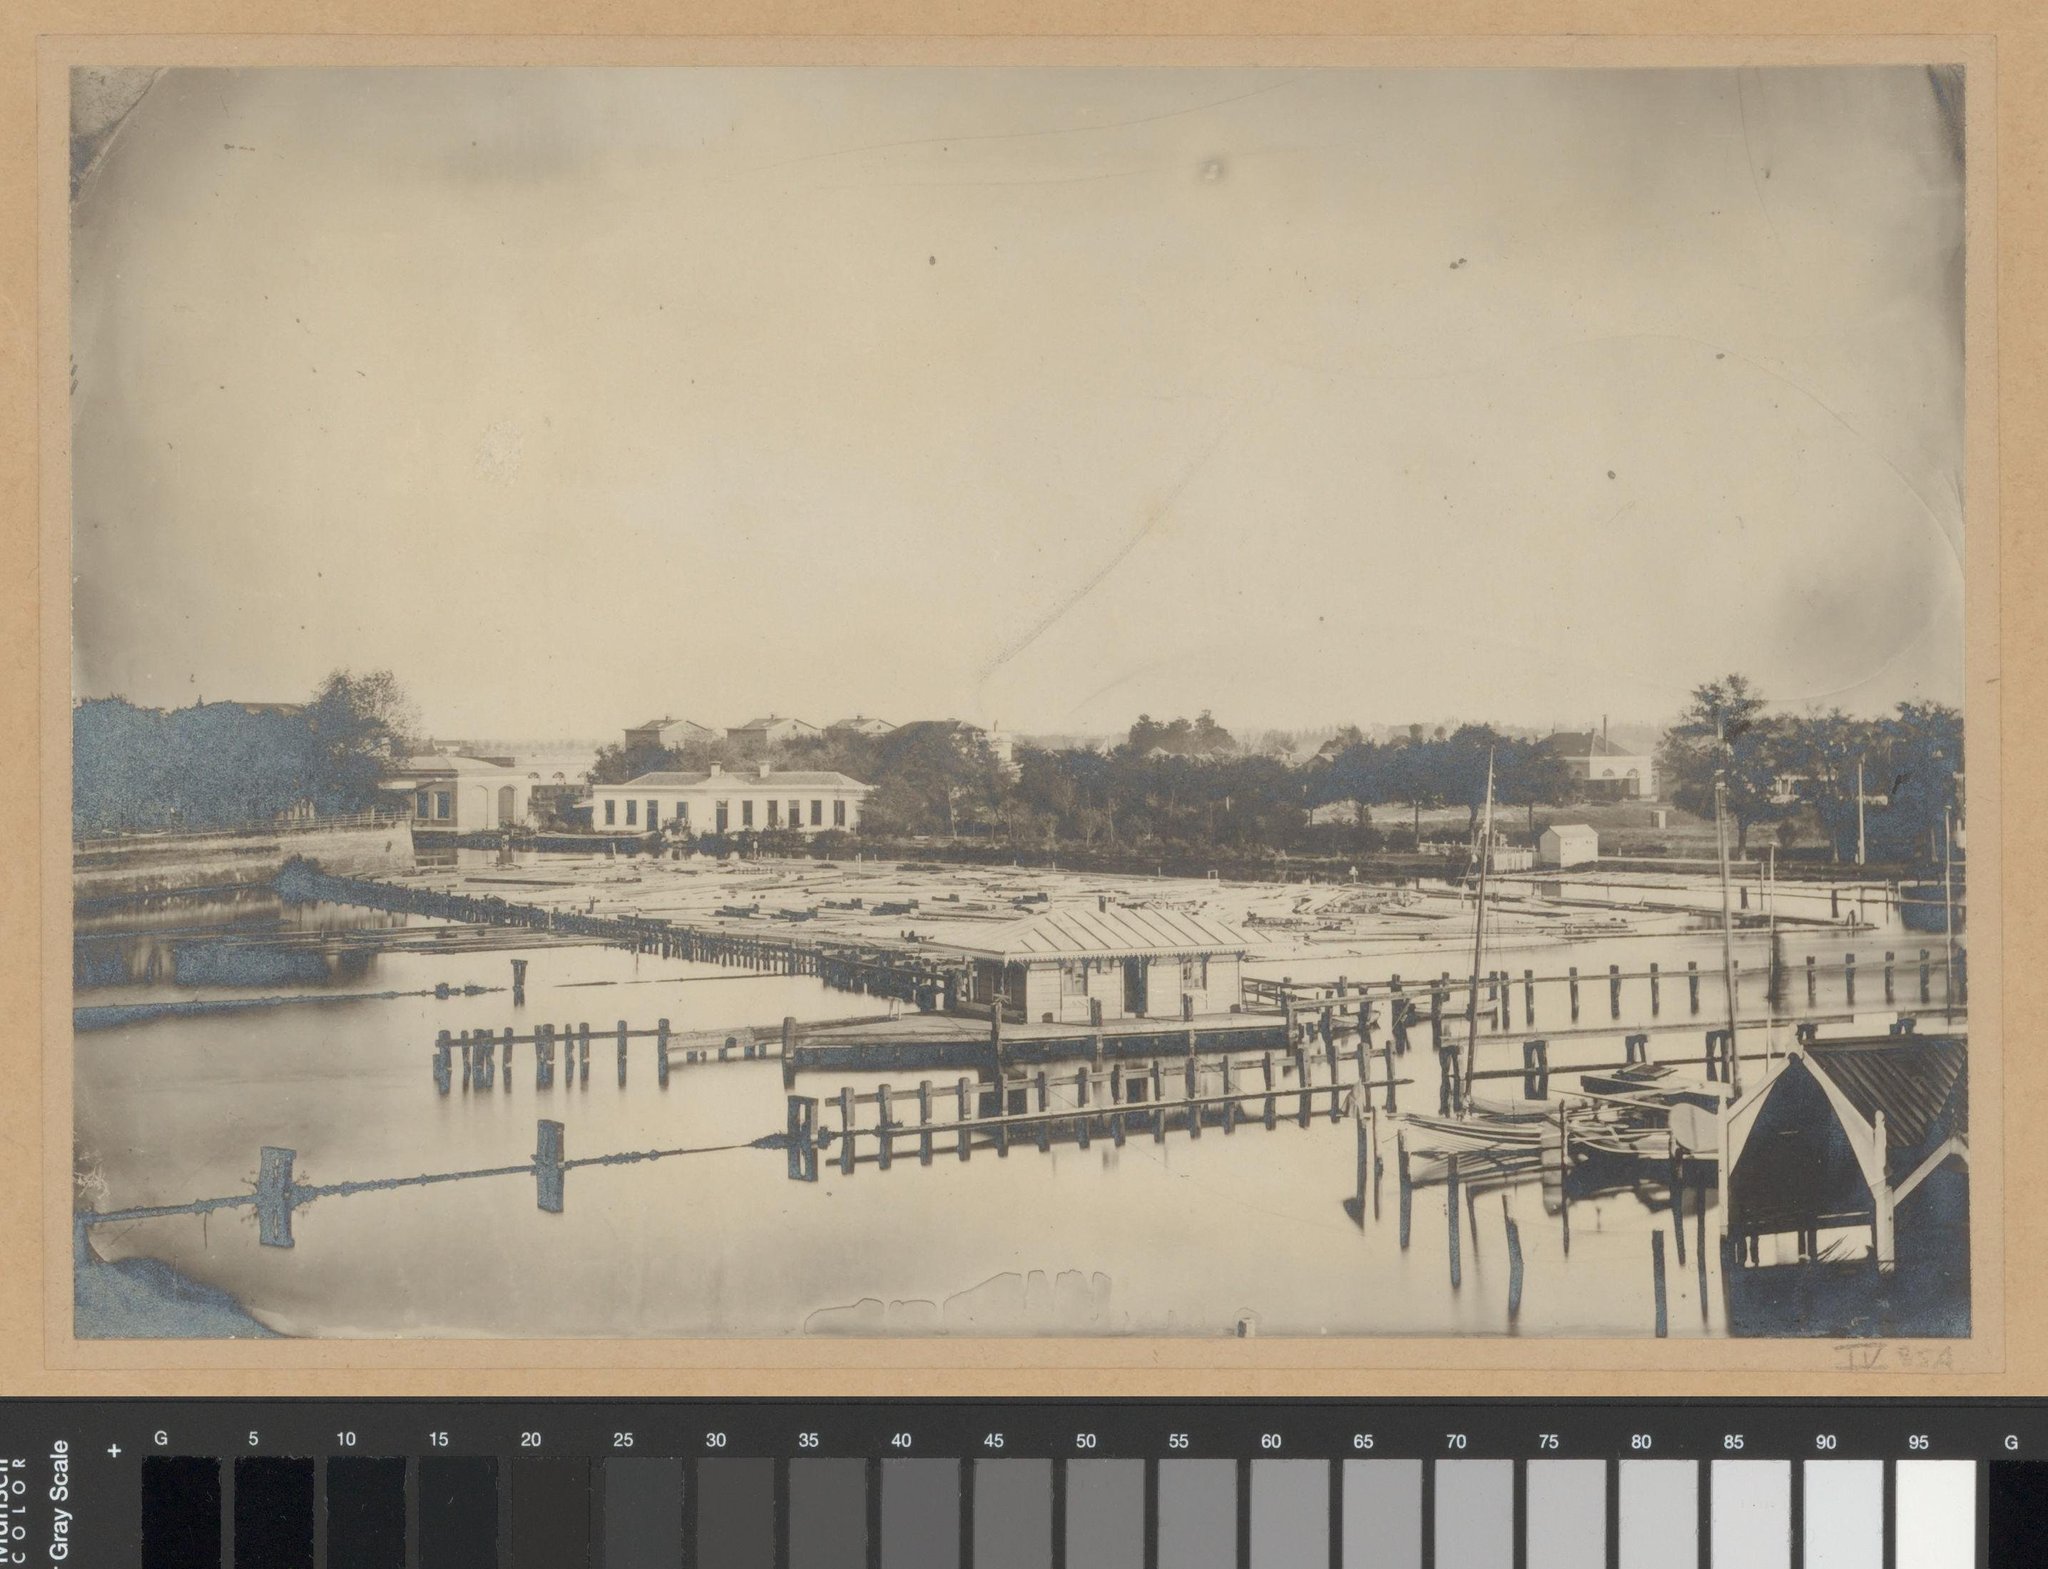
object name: photograph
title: Gezicht op de Amstel bij de Hogesluis gezien naar de Rhijnspoorweg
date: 1860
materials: cardboard, paper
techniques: gelatin silver print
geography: amsterdam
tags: city-view in general; 'veduta', river, railway, train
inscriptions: inscription: ‘Amstel b/d Hoogesluis ziende naar het Rhijnspoor / omstreeks 1860 / Geschenk van den heer J. van Eck. Juni 1919.’, collector's mark: ‘4C’ Lugt 1641b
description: Onderwerpsrubriek binnen de Atlas Amsterdam: Amstel van Hogesluis stroomopwaarts.